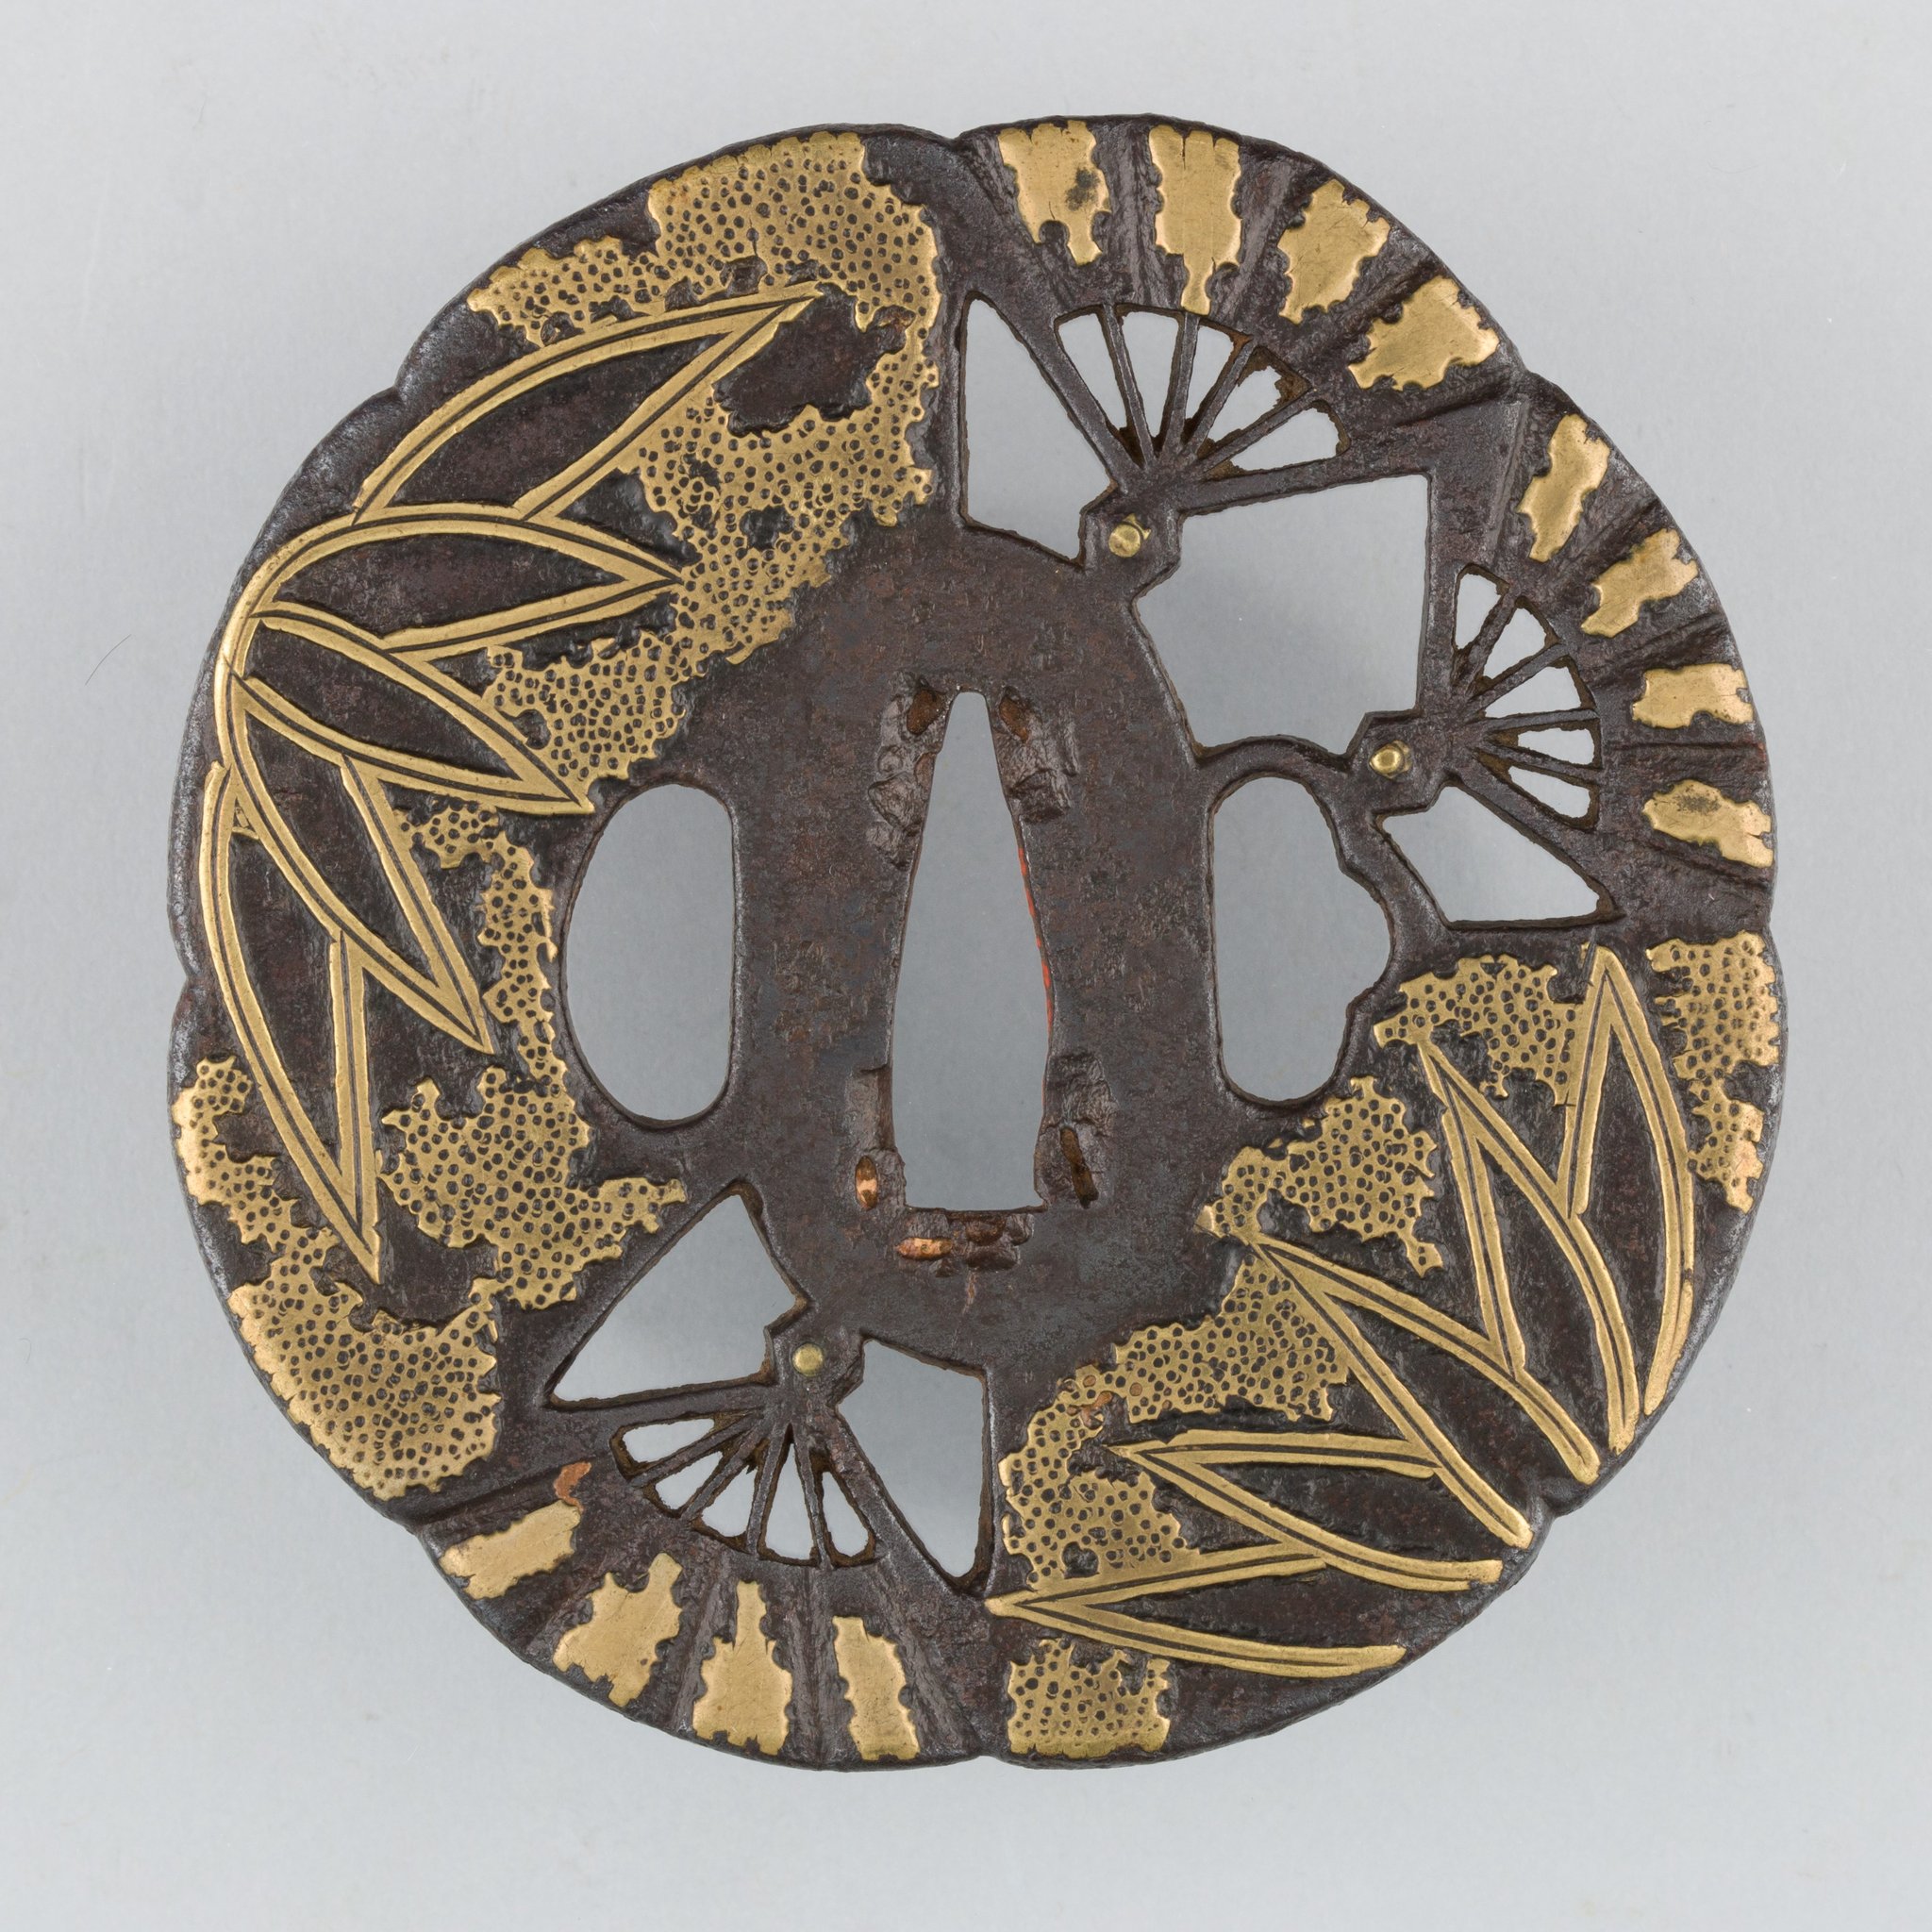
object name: sword guard tsuba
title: Sword Guard (Tsuba)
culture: japanese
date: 1601-1700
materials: brass, copper, iron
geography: japan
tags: fans